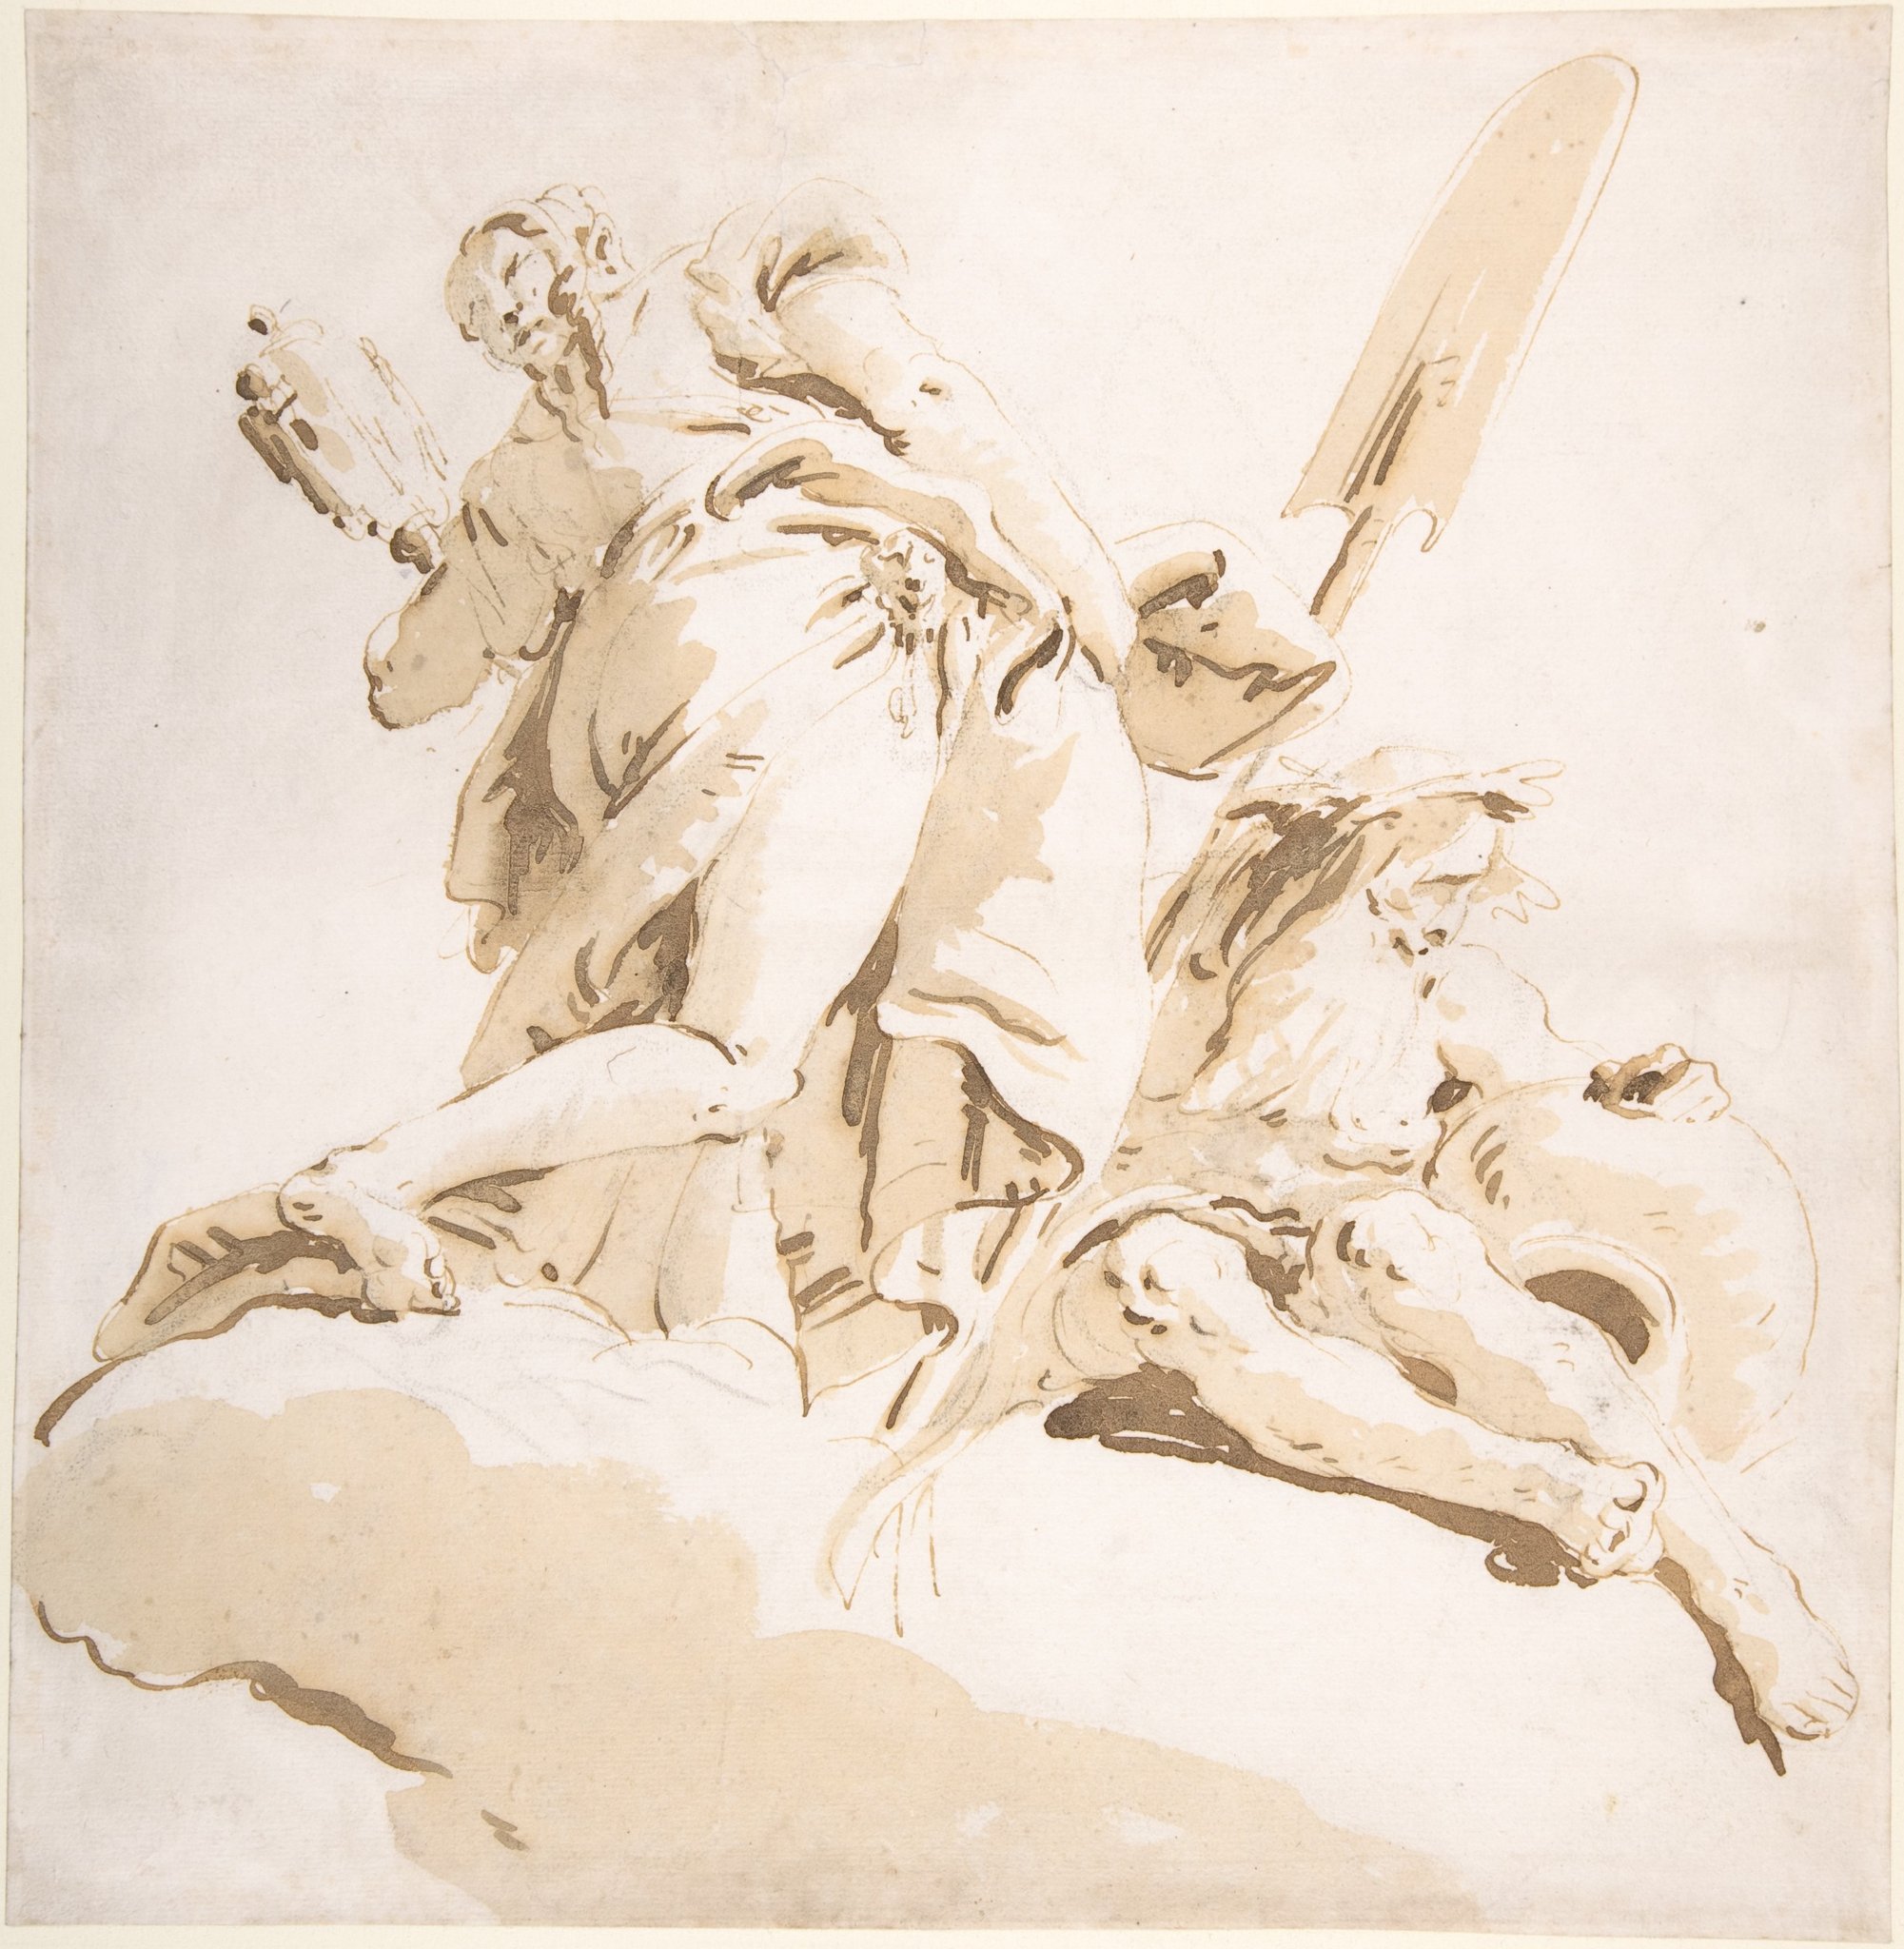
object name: drawing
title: Standing Figure of Prudence and a Seated River God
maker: giovanni battista tiepolo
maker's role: artist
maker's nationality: italian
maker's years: 1696-1770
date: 1696-1770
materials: chalk, ink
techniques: brush, pen, wash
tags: human figures,poseidon